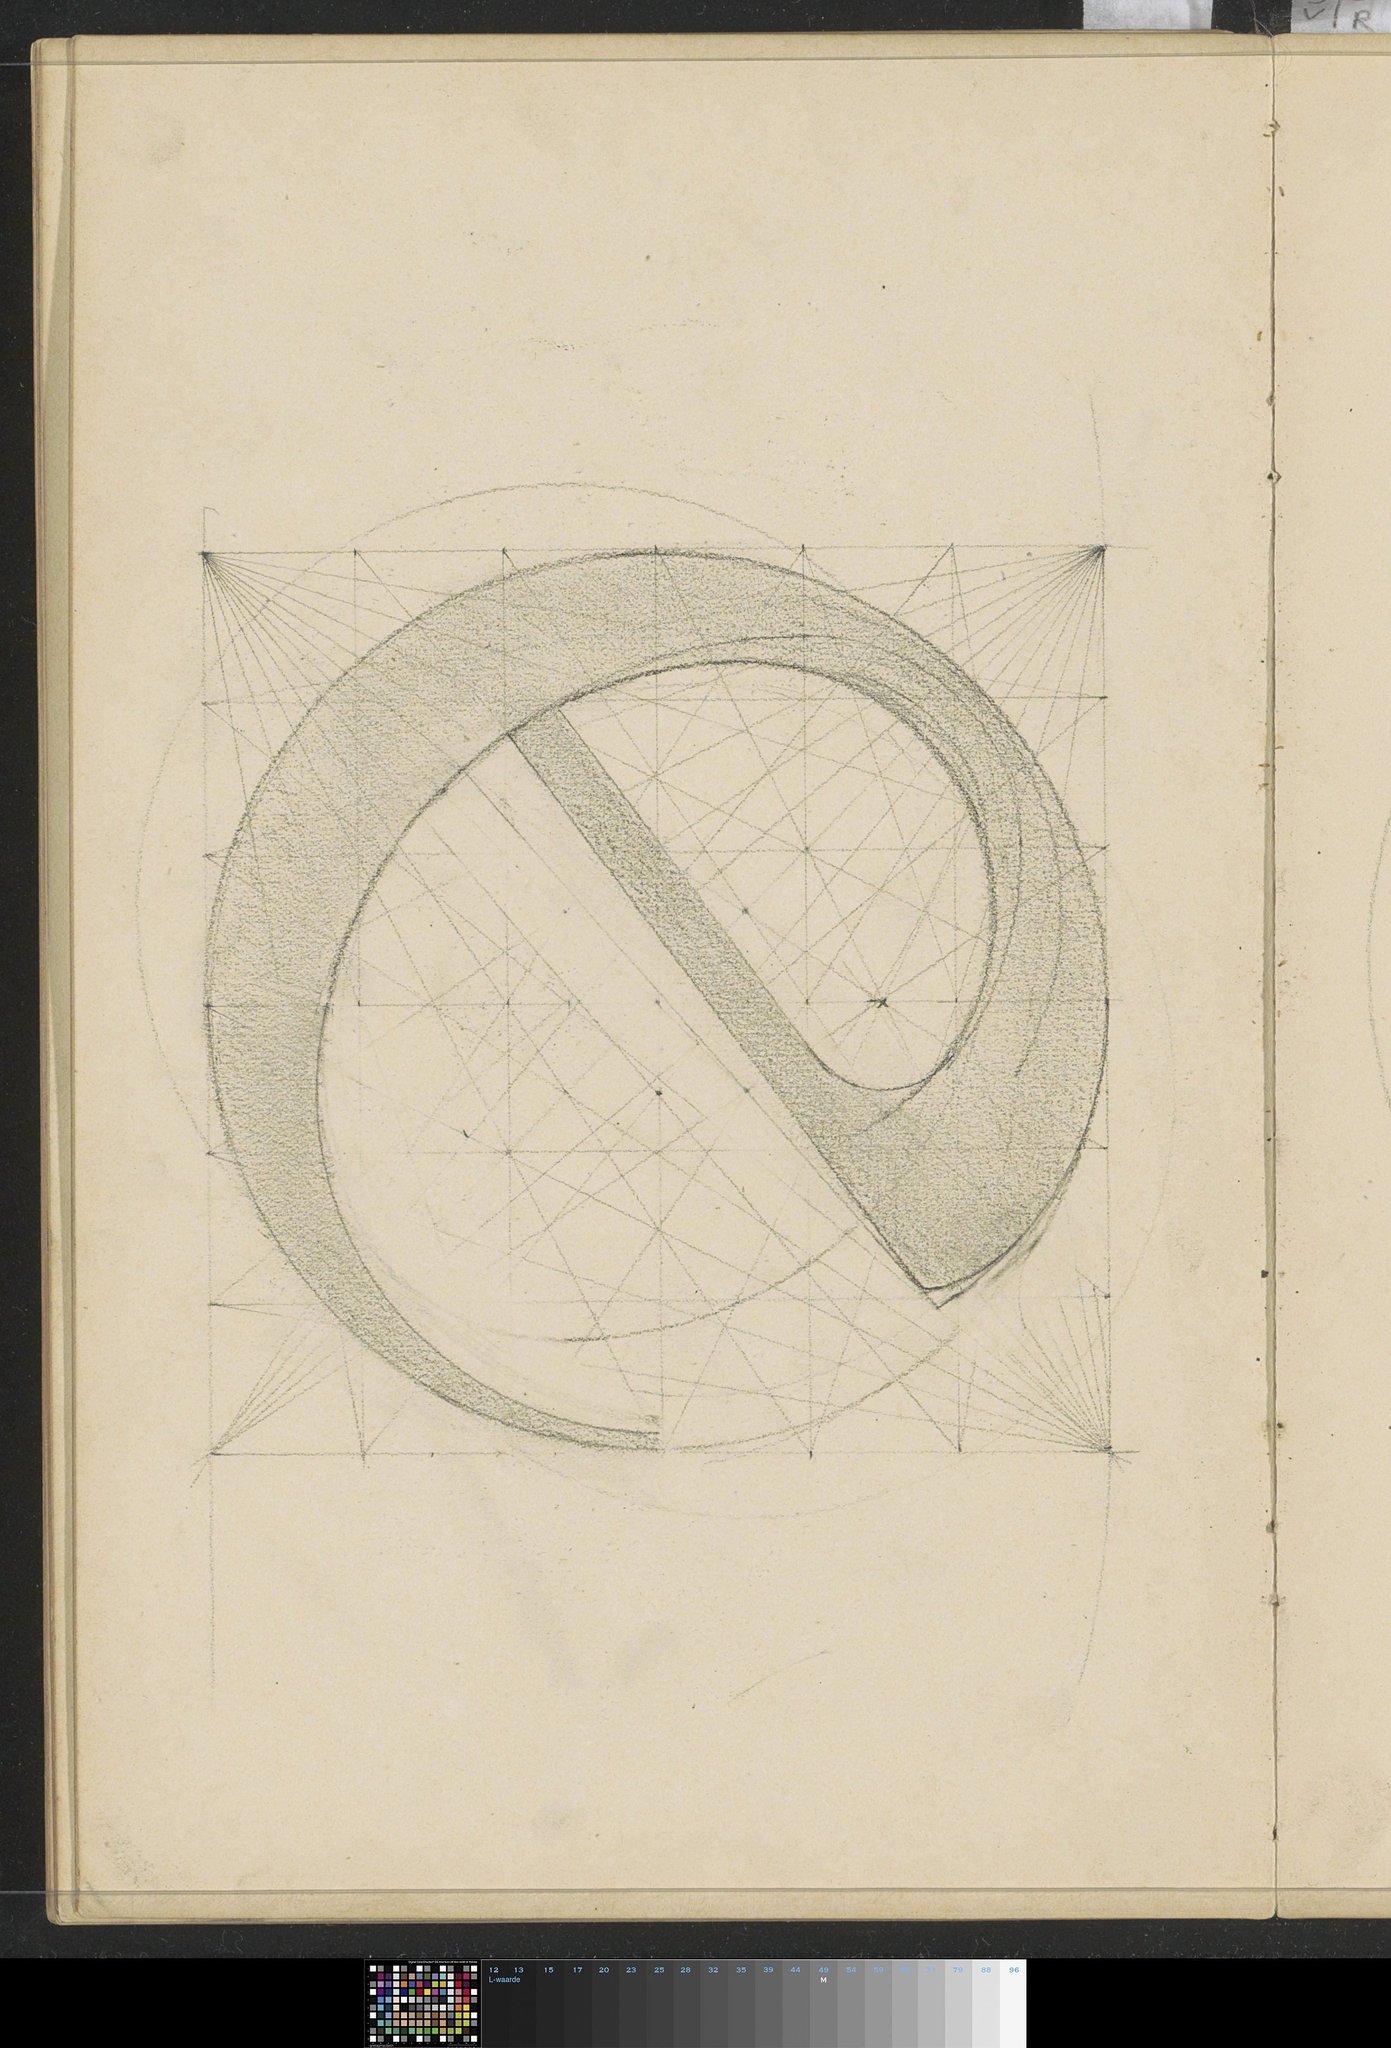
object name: sketchbook leaf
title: Letter 'e'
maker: antoon derkinderen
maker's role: draughtsman, painter, print maker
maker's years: 1859-1925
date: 1889-1894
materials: paper, pencil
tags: fancy letters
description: Blad 18 verso uit een schetsboek met 33 bladen.